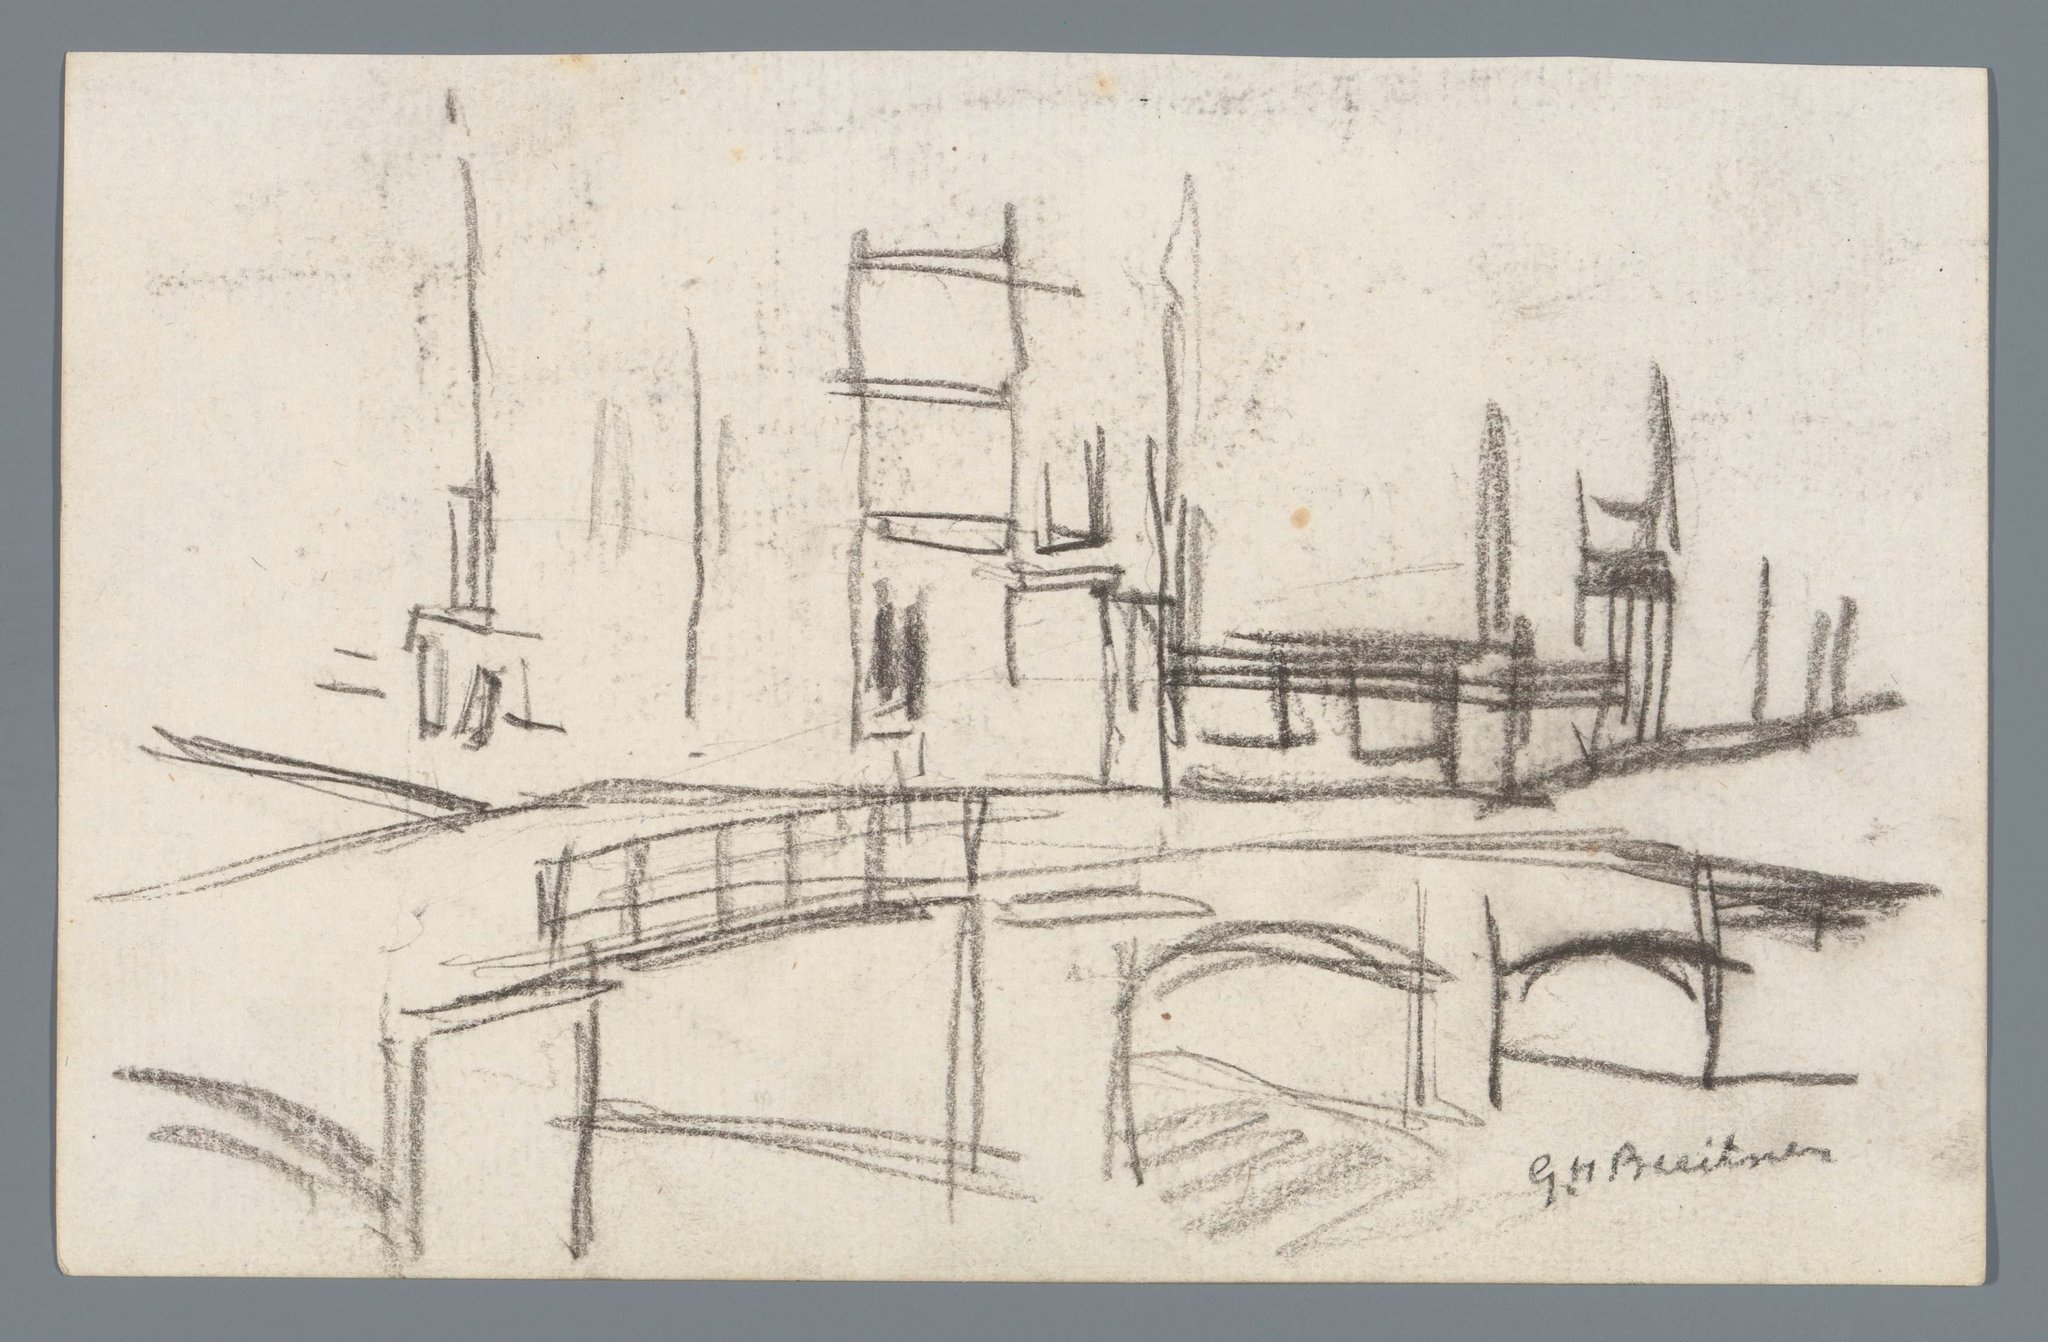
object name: drawing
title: Langebrug en de Langebrugsteeg te Amsterdam, gezien vanaf het Rokin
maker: george hendrik breitner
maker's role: draughtsman, painter, print maker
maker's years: 1857-1923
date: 1886-1923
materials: chalk, paper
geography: amsterdam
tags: lane, alley, bridge in city across river, canal, etc.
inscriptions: signature: ‘G.H Breitner’